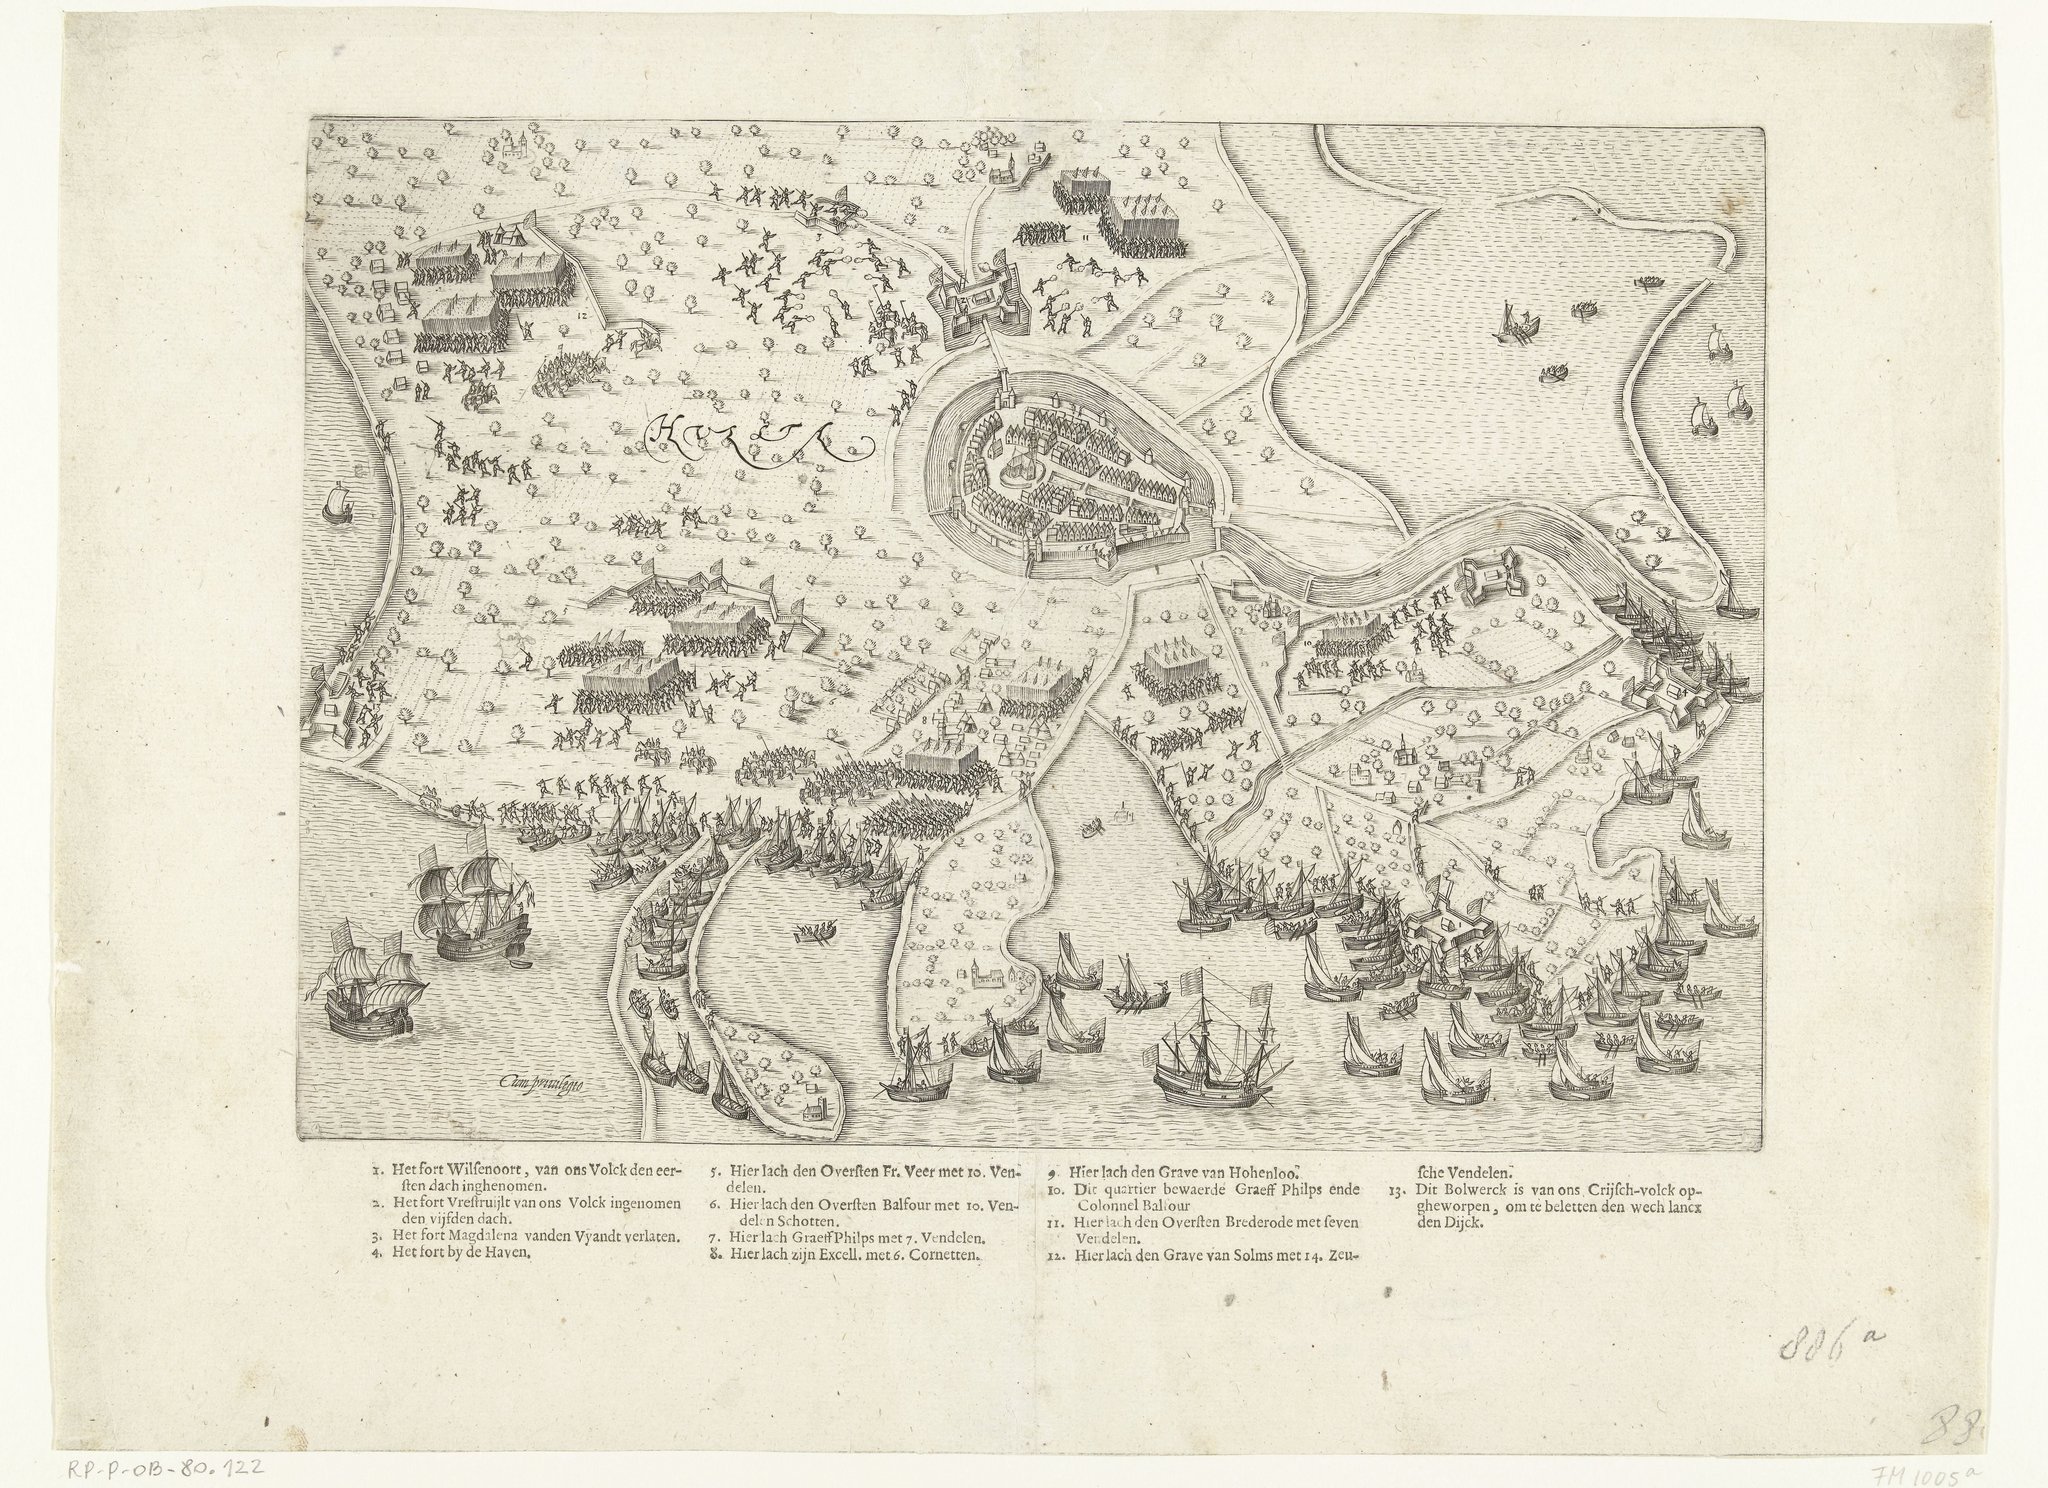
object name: history print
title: Beleg en inname van Hulst door Maurits, 1591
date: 1600-1601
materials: paper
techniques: engraving, letterpress printing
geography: northern netherlands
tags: maurice (prince of orange), siege, position war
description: Gebruikt als illustratie in: J.J. Orlers, Den Nassauschen Lauren-Crans: Beschrijvinghe ende af-beeldinge van alle de victorien ... die Godt Almachtich de ... Staten der Vereenichde Nederlanden verleent heeft, deur het wijs ende clouck beleyt des Hooch-ghebooren Fursts Maurits van Nassau, J.J. Orlers en H. van Haestens, Leiden 1610, fol. 82/83.